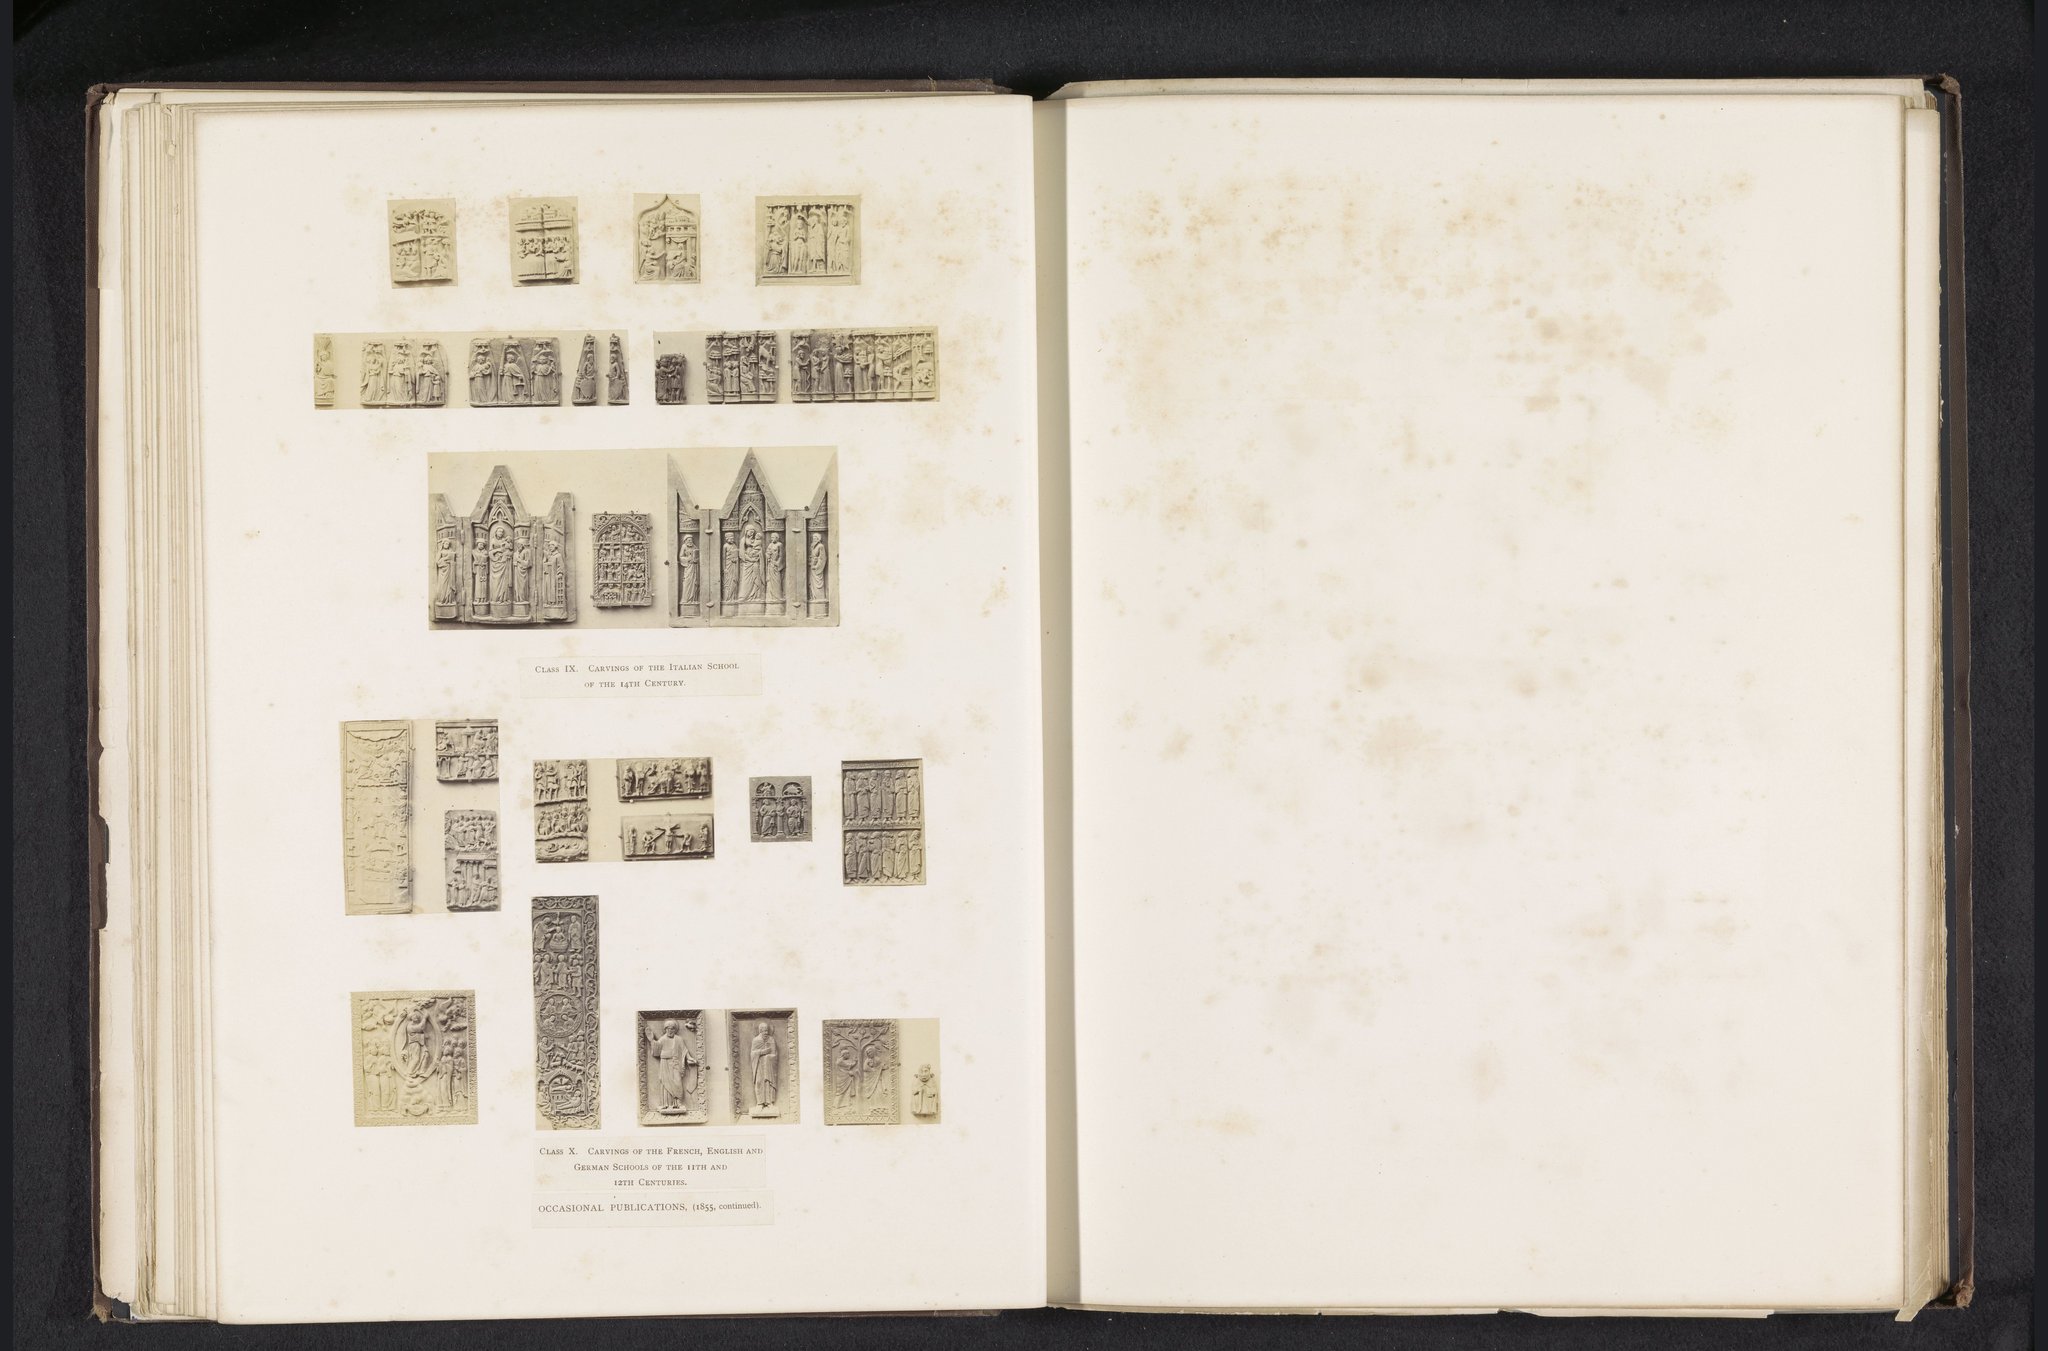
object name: photograph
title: Vijftien fotoreproducties van publicaties door de Arundel Society met reliëfs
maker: Anonymous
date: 1859-1869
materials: photographic support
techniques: albumen print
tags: book, sculpture (+ relief ~ sculpture)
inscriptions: inscription: ‘Class IX. Carvings of the Italian school of the 14th century (...) occasional publications, (1855, continued).’